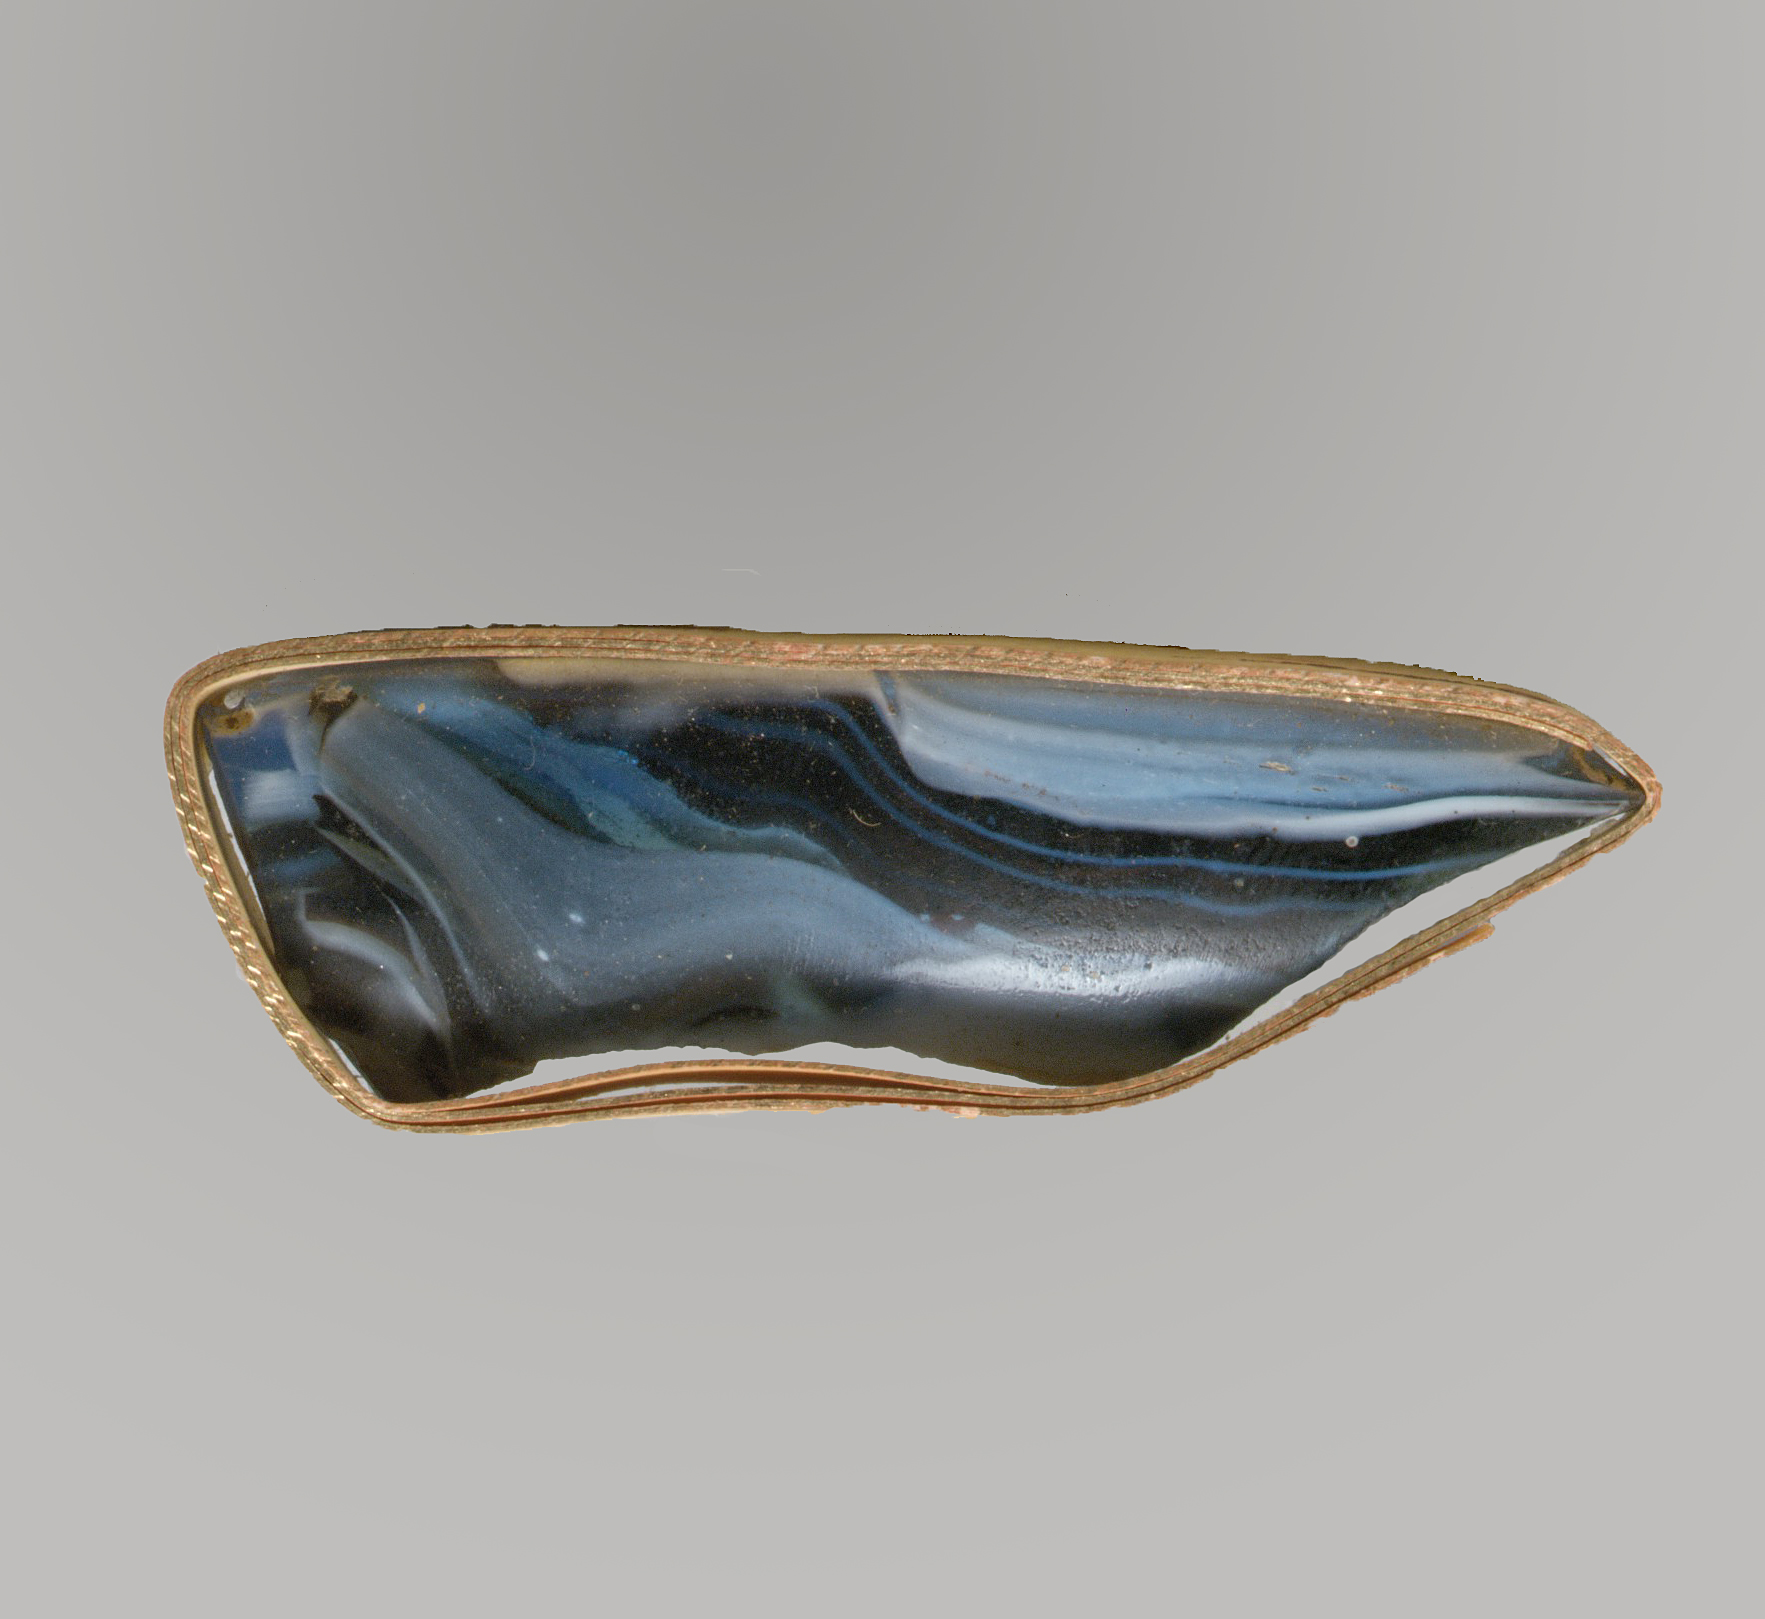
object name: fragment, mosaic dish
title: Glass mosaic dish fragment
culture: roman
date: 34 BCE-33 CE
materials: glass